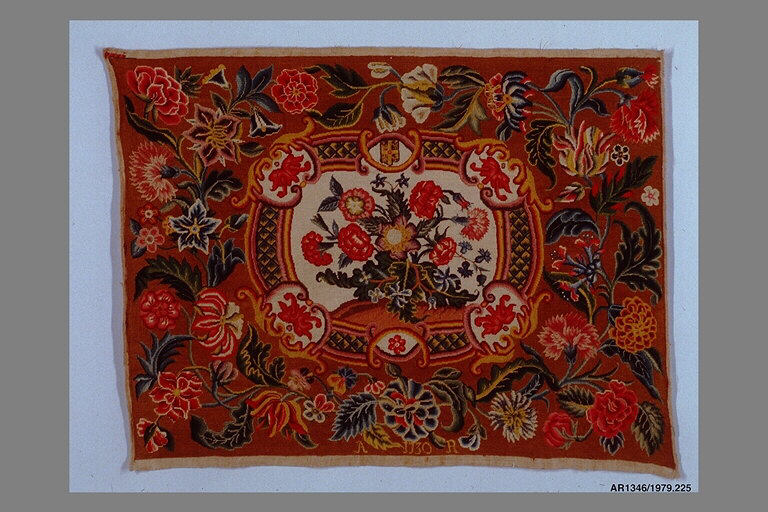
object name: panel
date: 1730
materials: linen, silk, wool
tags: flowers